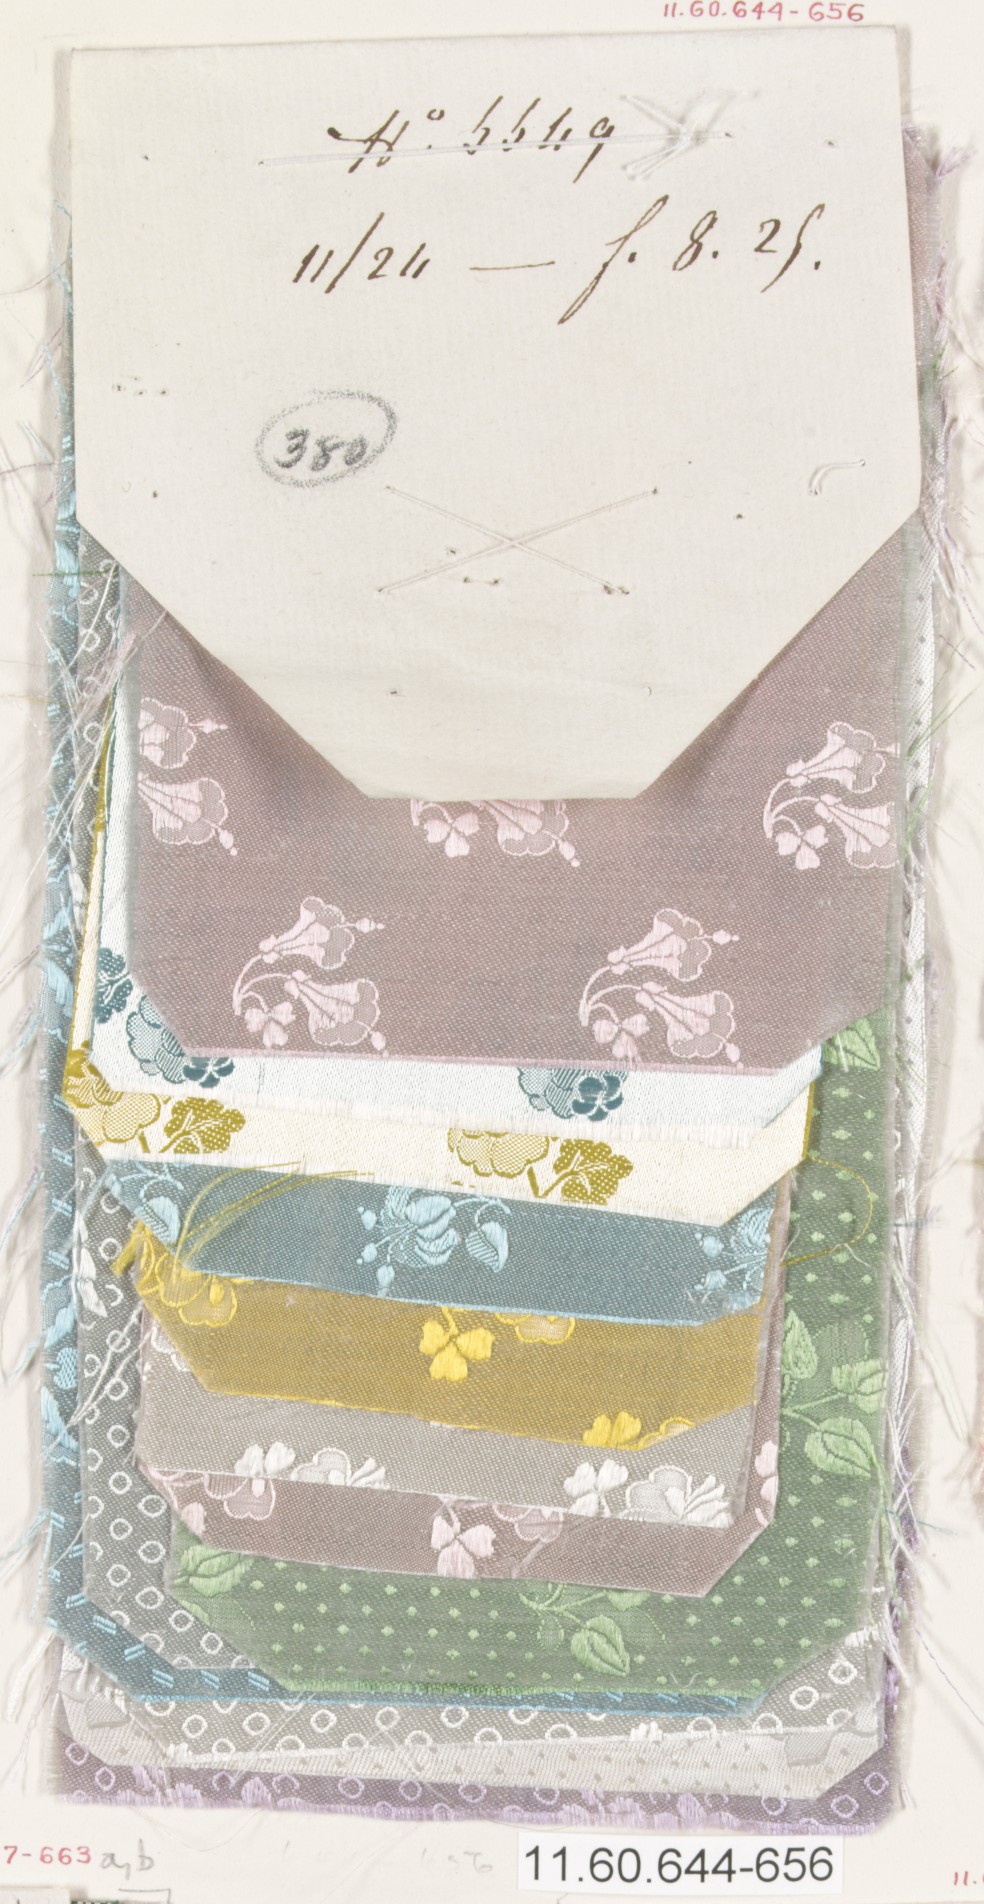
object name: sample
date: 1801-1833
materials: silk